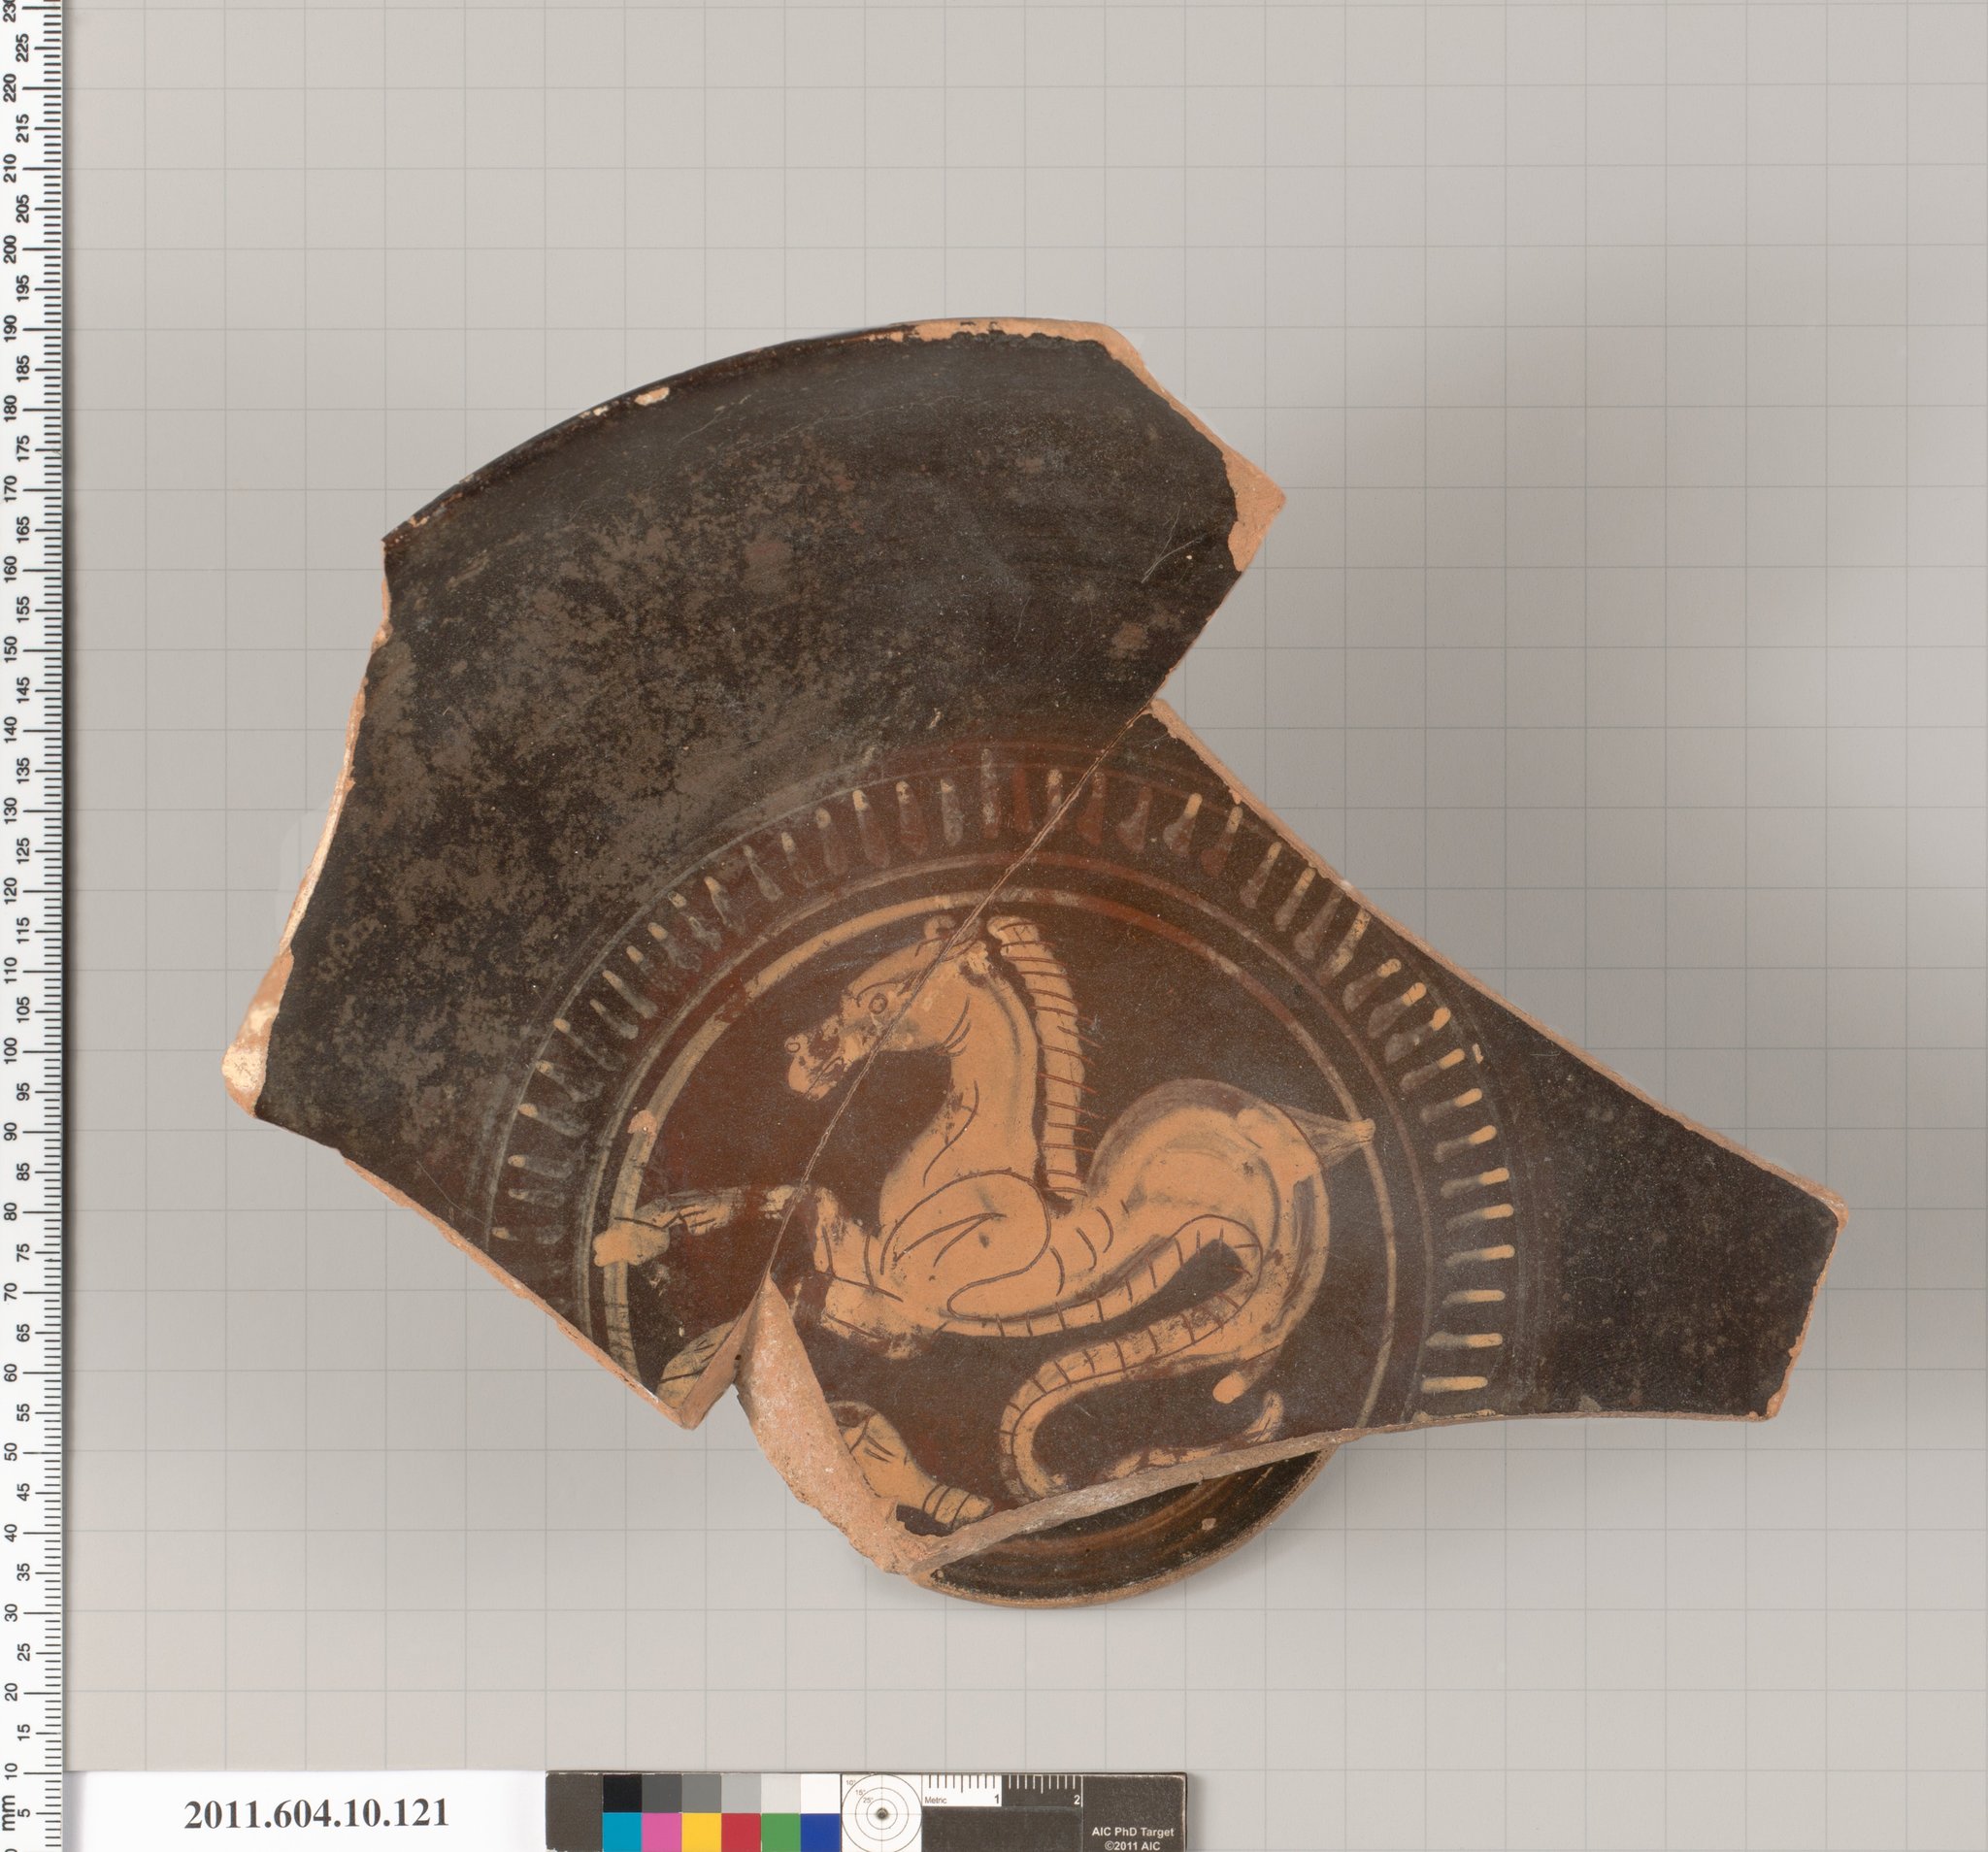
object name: kylix fragment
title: Terracotta fragment of a kylix (drinking cup)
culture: etruscan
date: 434-368 BCE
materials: terracotta